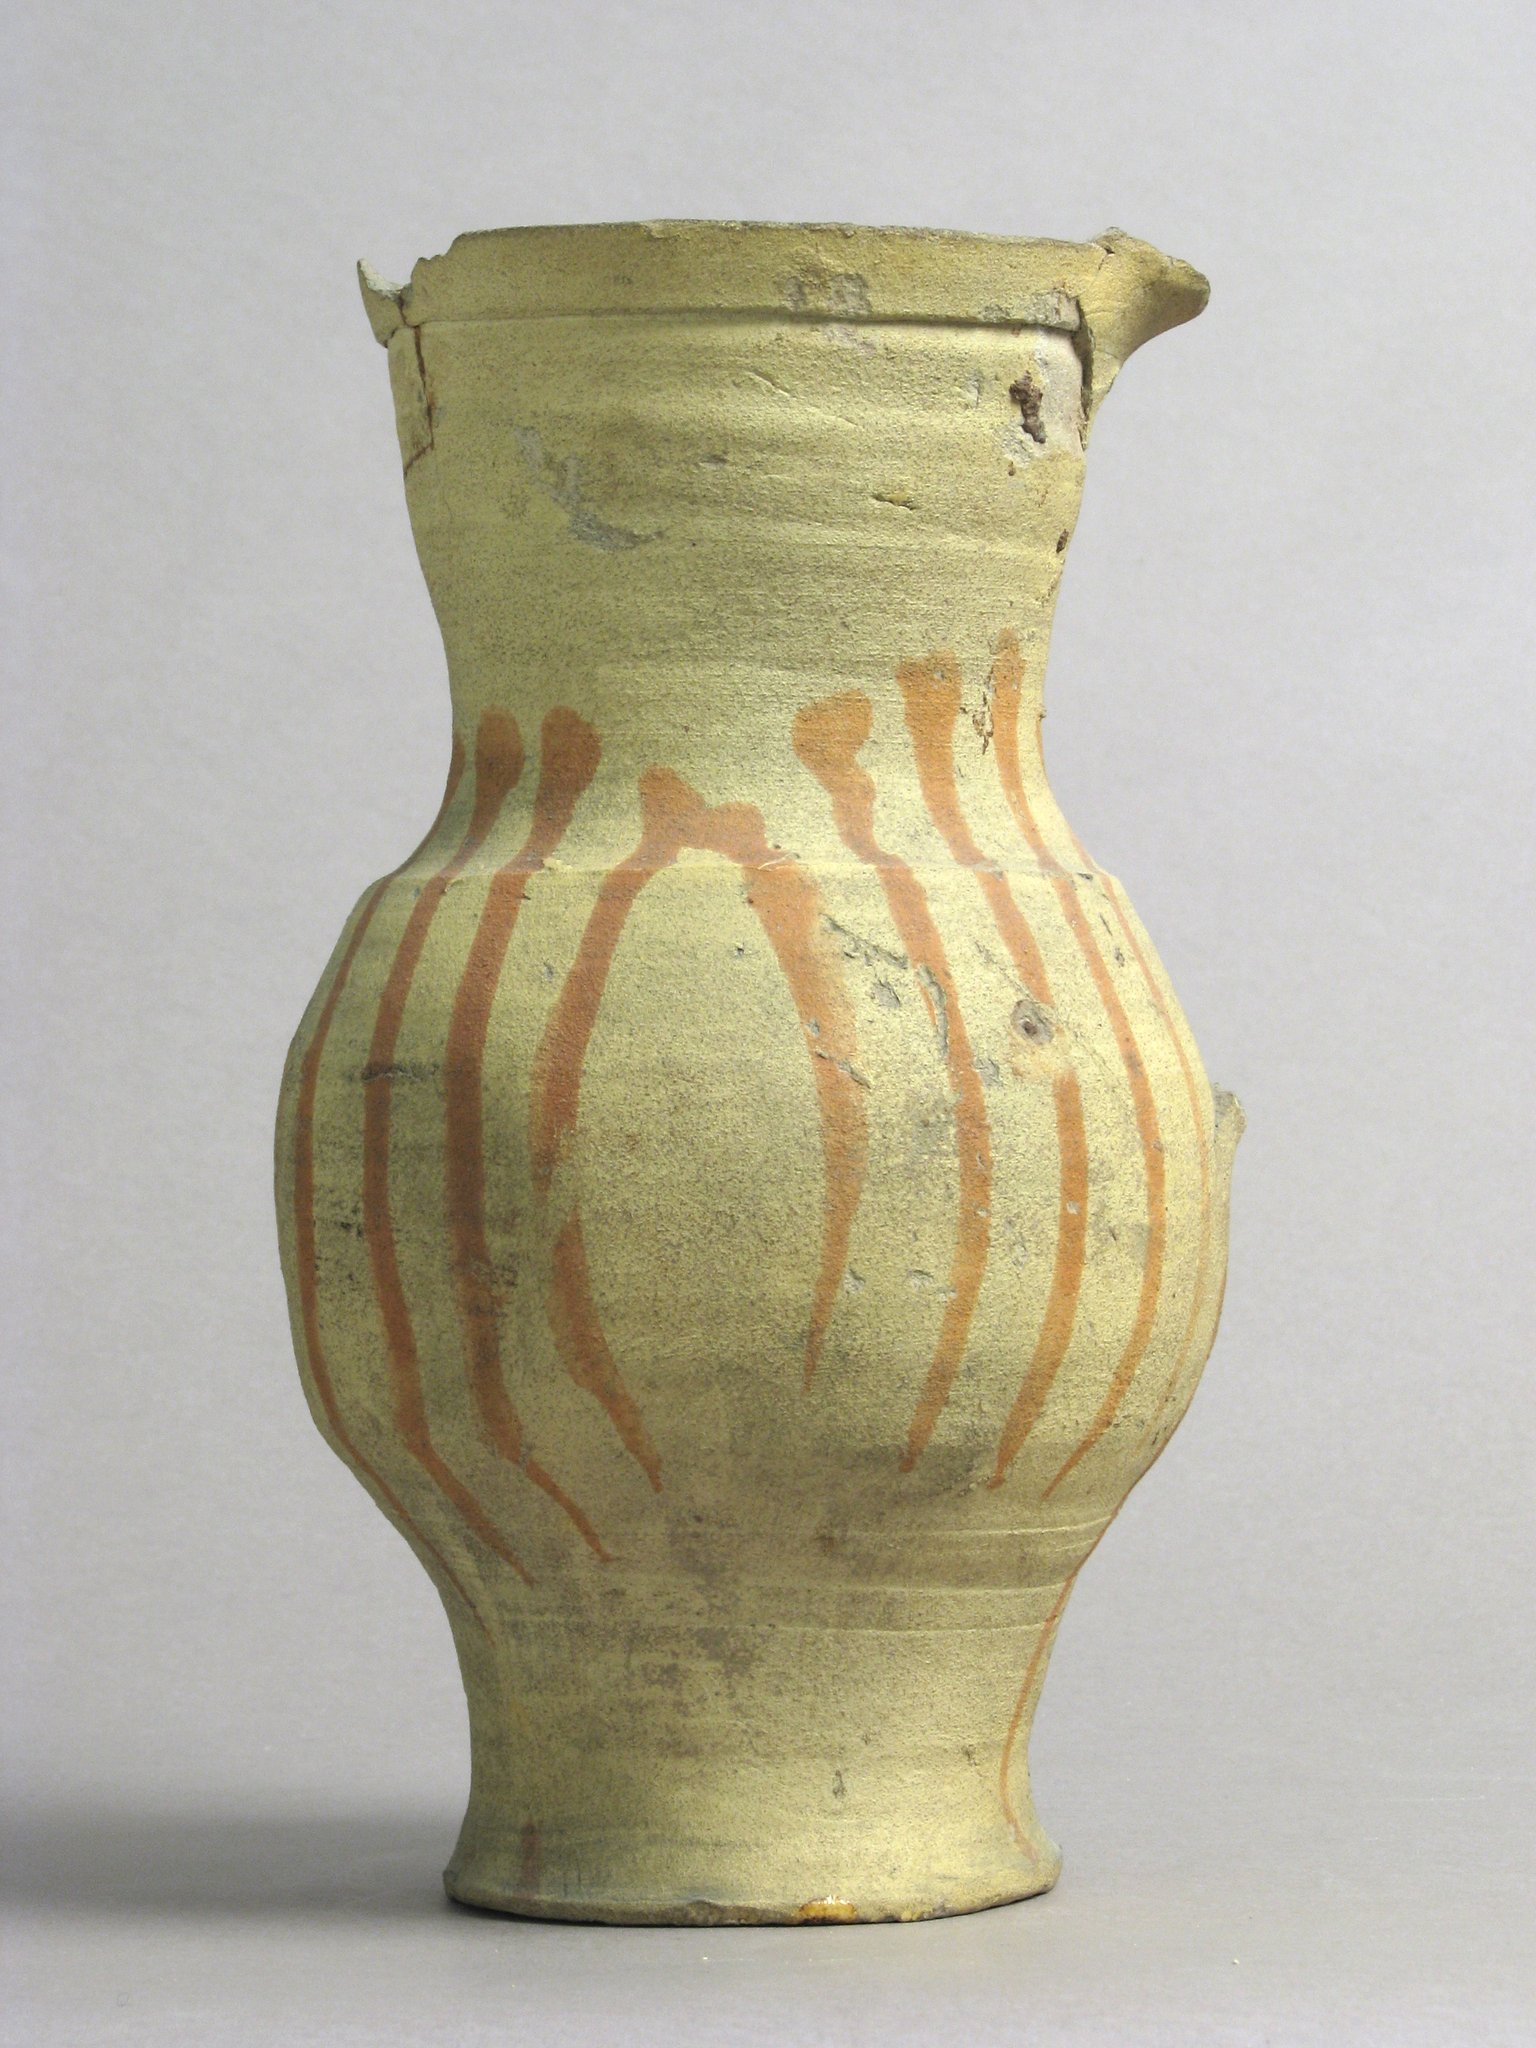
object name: jar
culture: french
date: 1201-1400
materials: earthenware